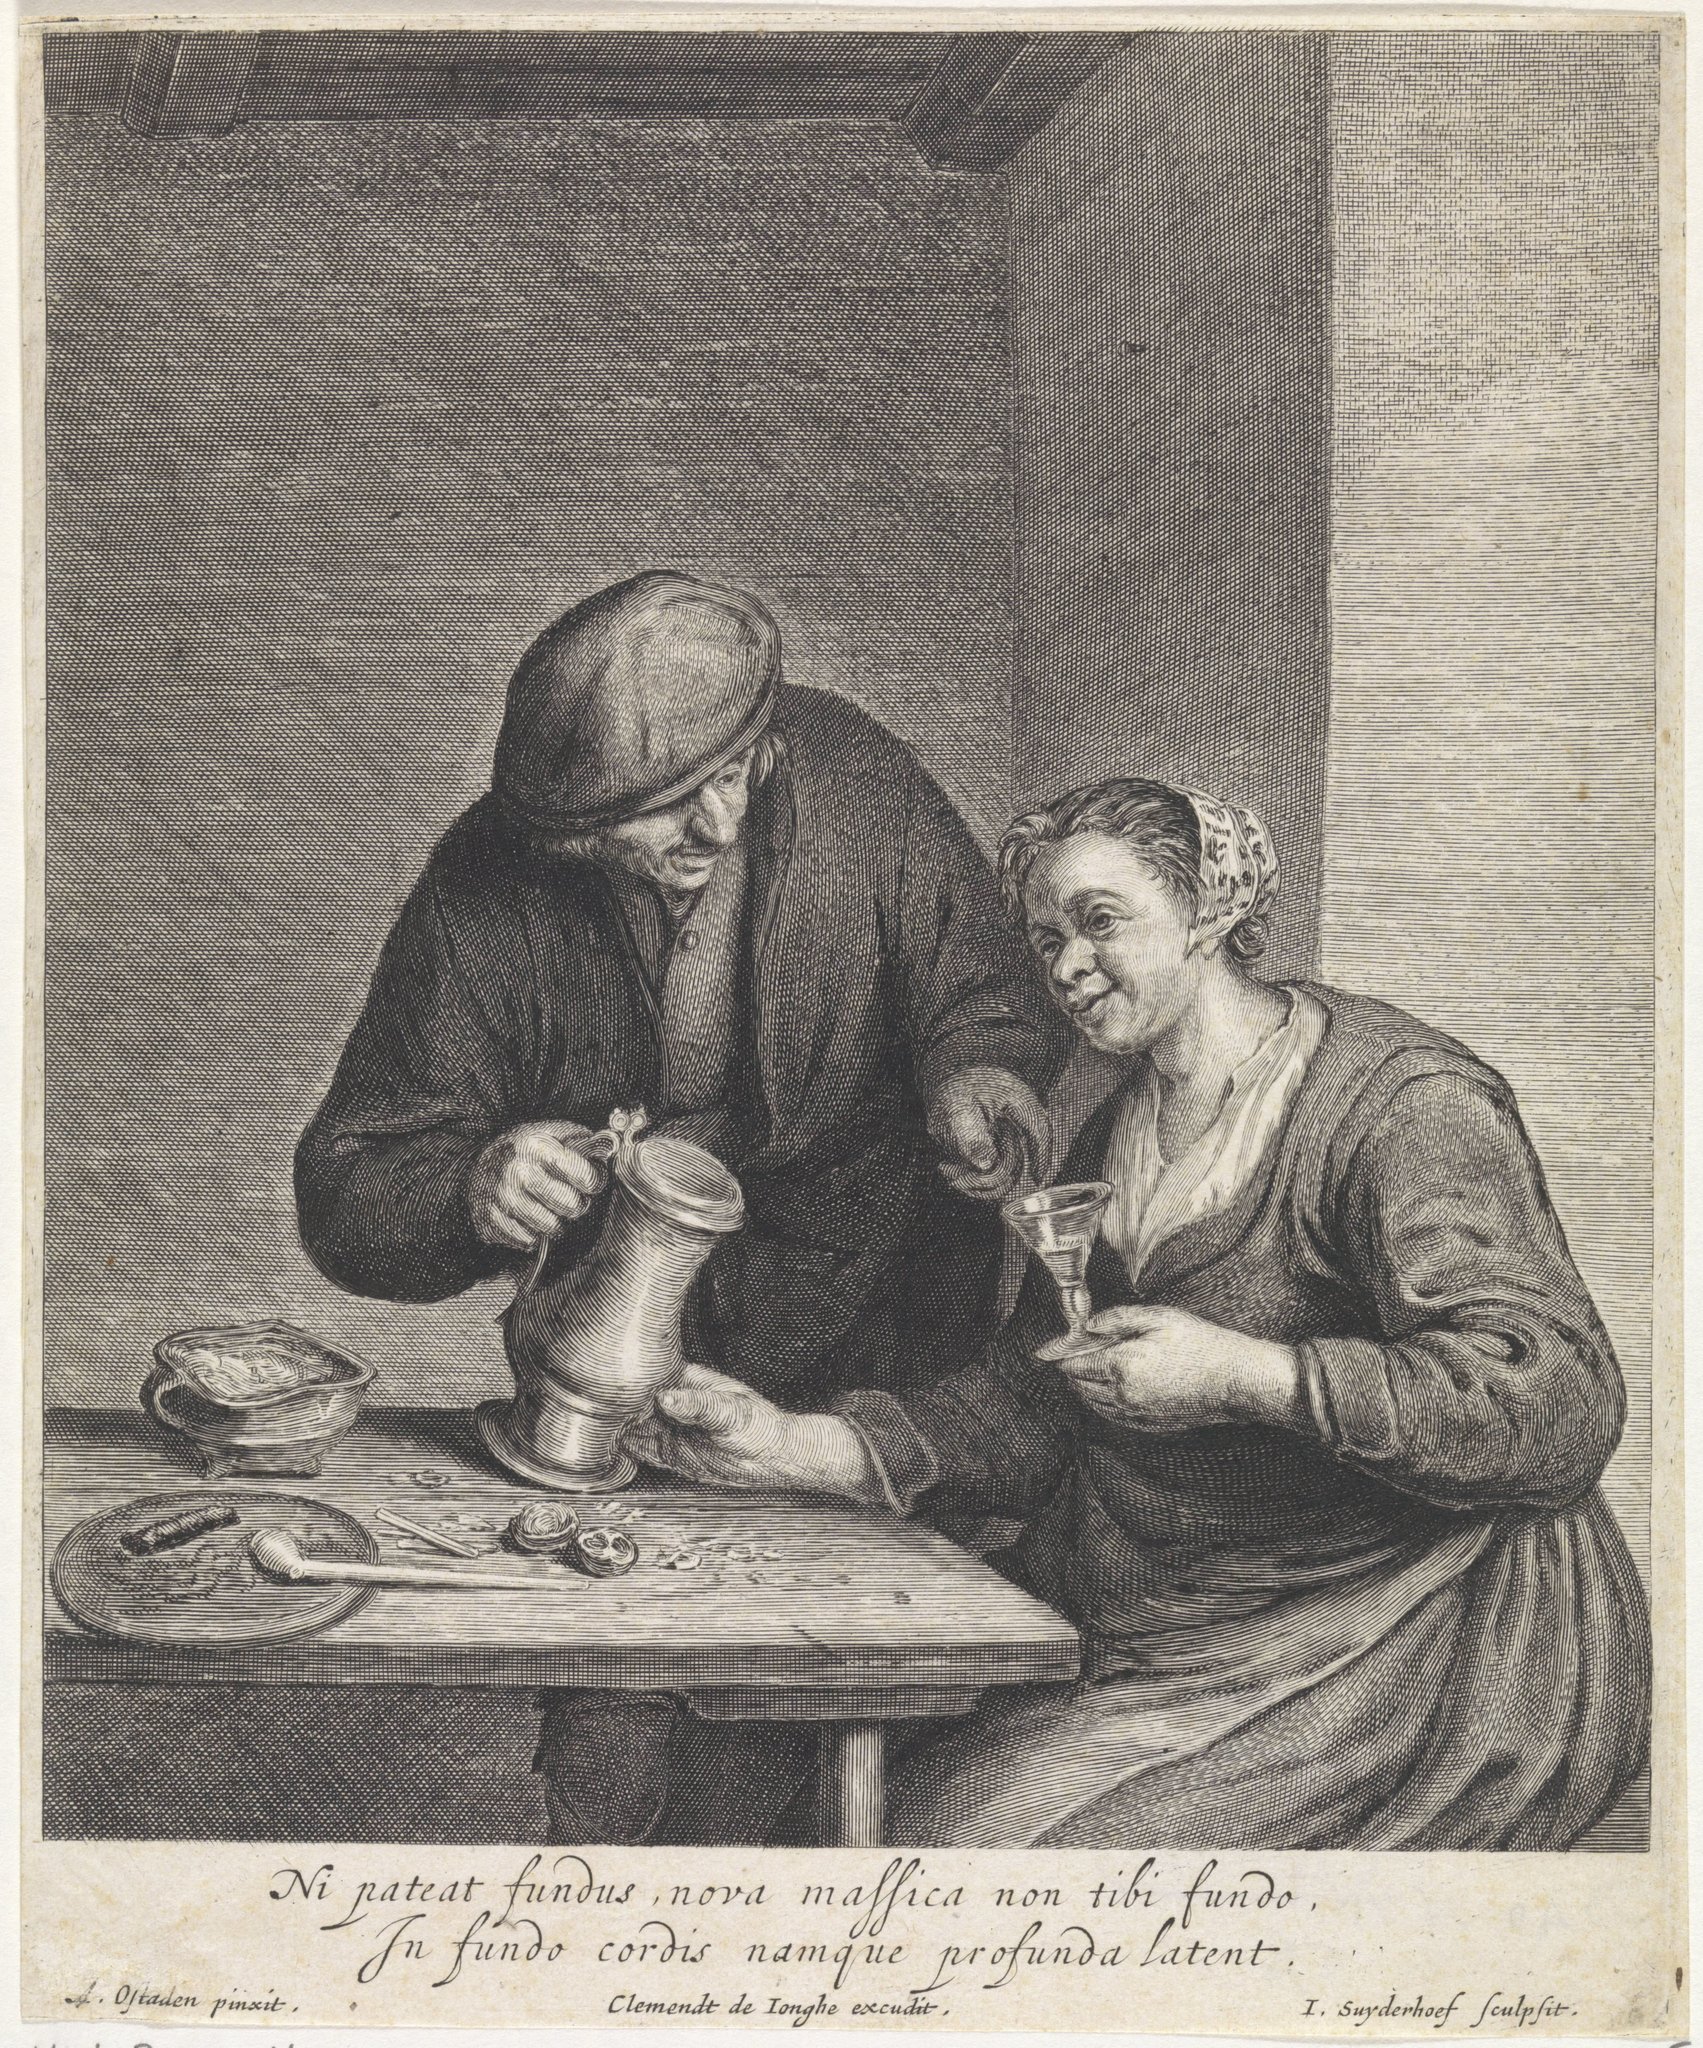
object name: print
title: Boerenpaar bij een tafel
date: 1643-1677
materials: paper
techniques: engraving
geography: haarlem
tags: pipe ~ tobacco, jar, jug (used as drinking-vessel), farmers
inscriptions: collector's mark: Lugt 11, collector's mark: ‘Hinloopen’, collector's mark: Lugt 10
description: Een boerenvrouw zit aan een tafel met een glas in de hand. Naast haar een boer die op haar glas wijst en met de kan in zijn handen aanstalten maakt om bij te schenken. Op tafel een vuurtest en een pijp.